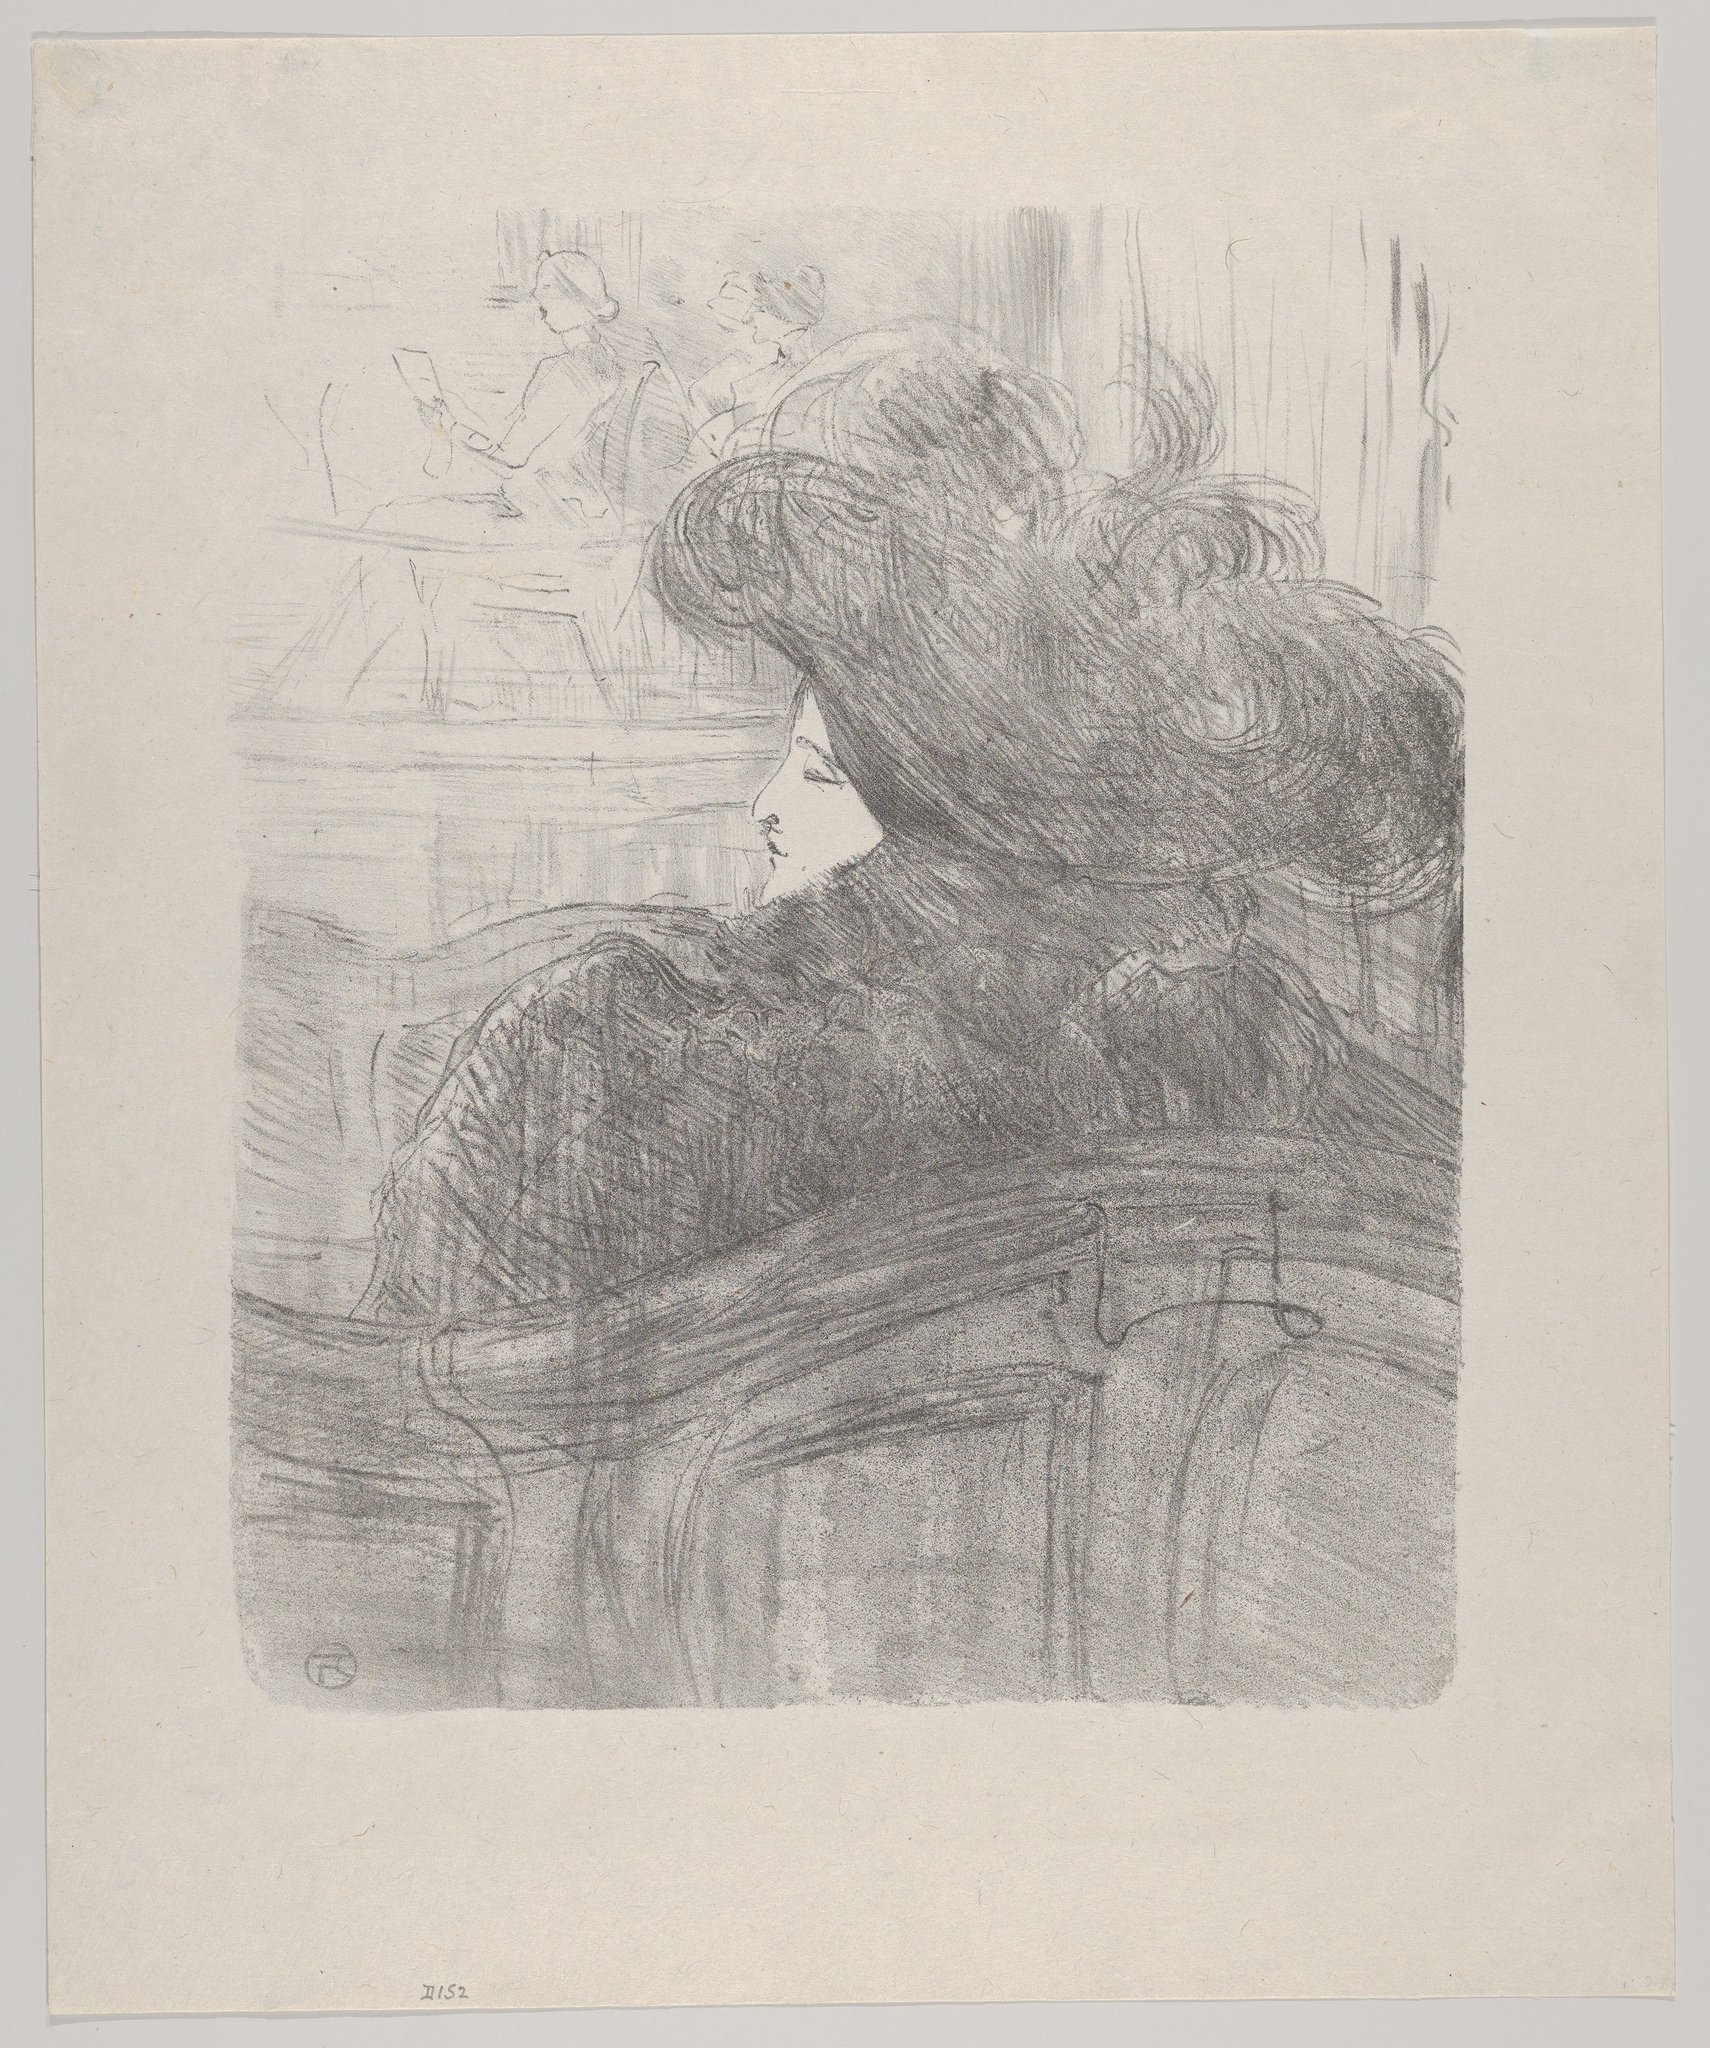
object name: print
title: Cléo de Mérode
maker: henri de toulouse-lautrec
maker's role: artist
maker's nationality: french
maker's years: 1864-1901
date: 1898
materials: paper, crayon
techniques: lithograph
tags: women,dancers